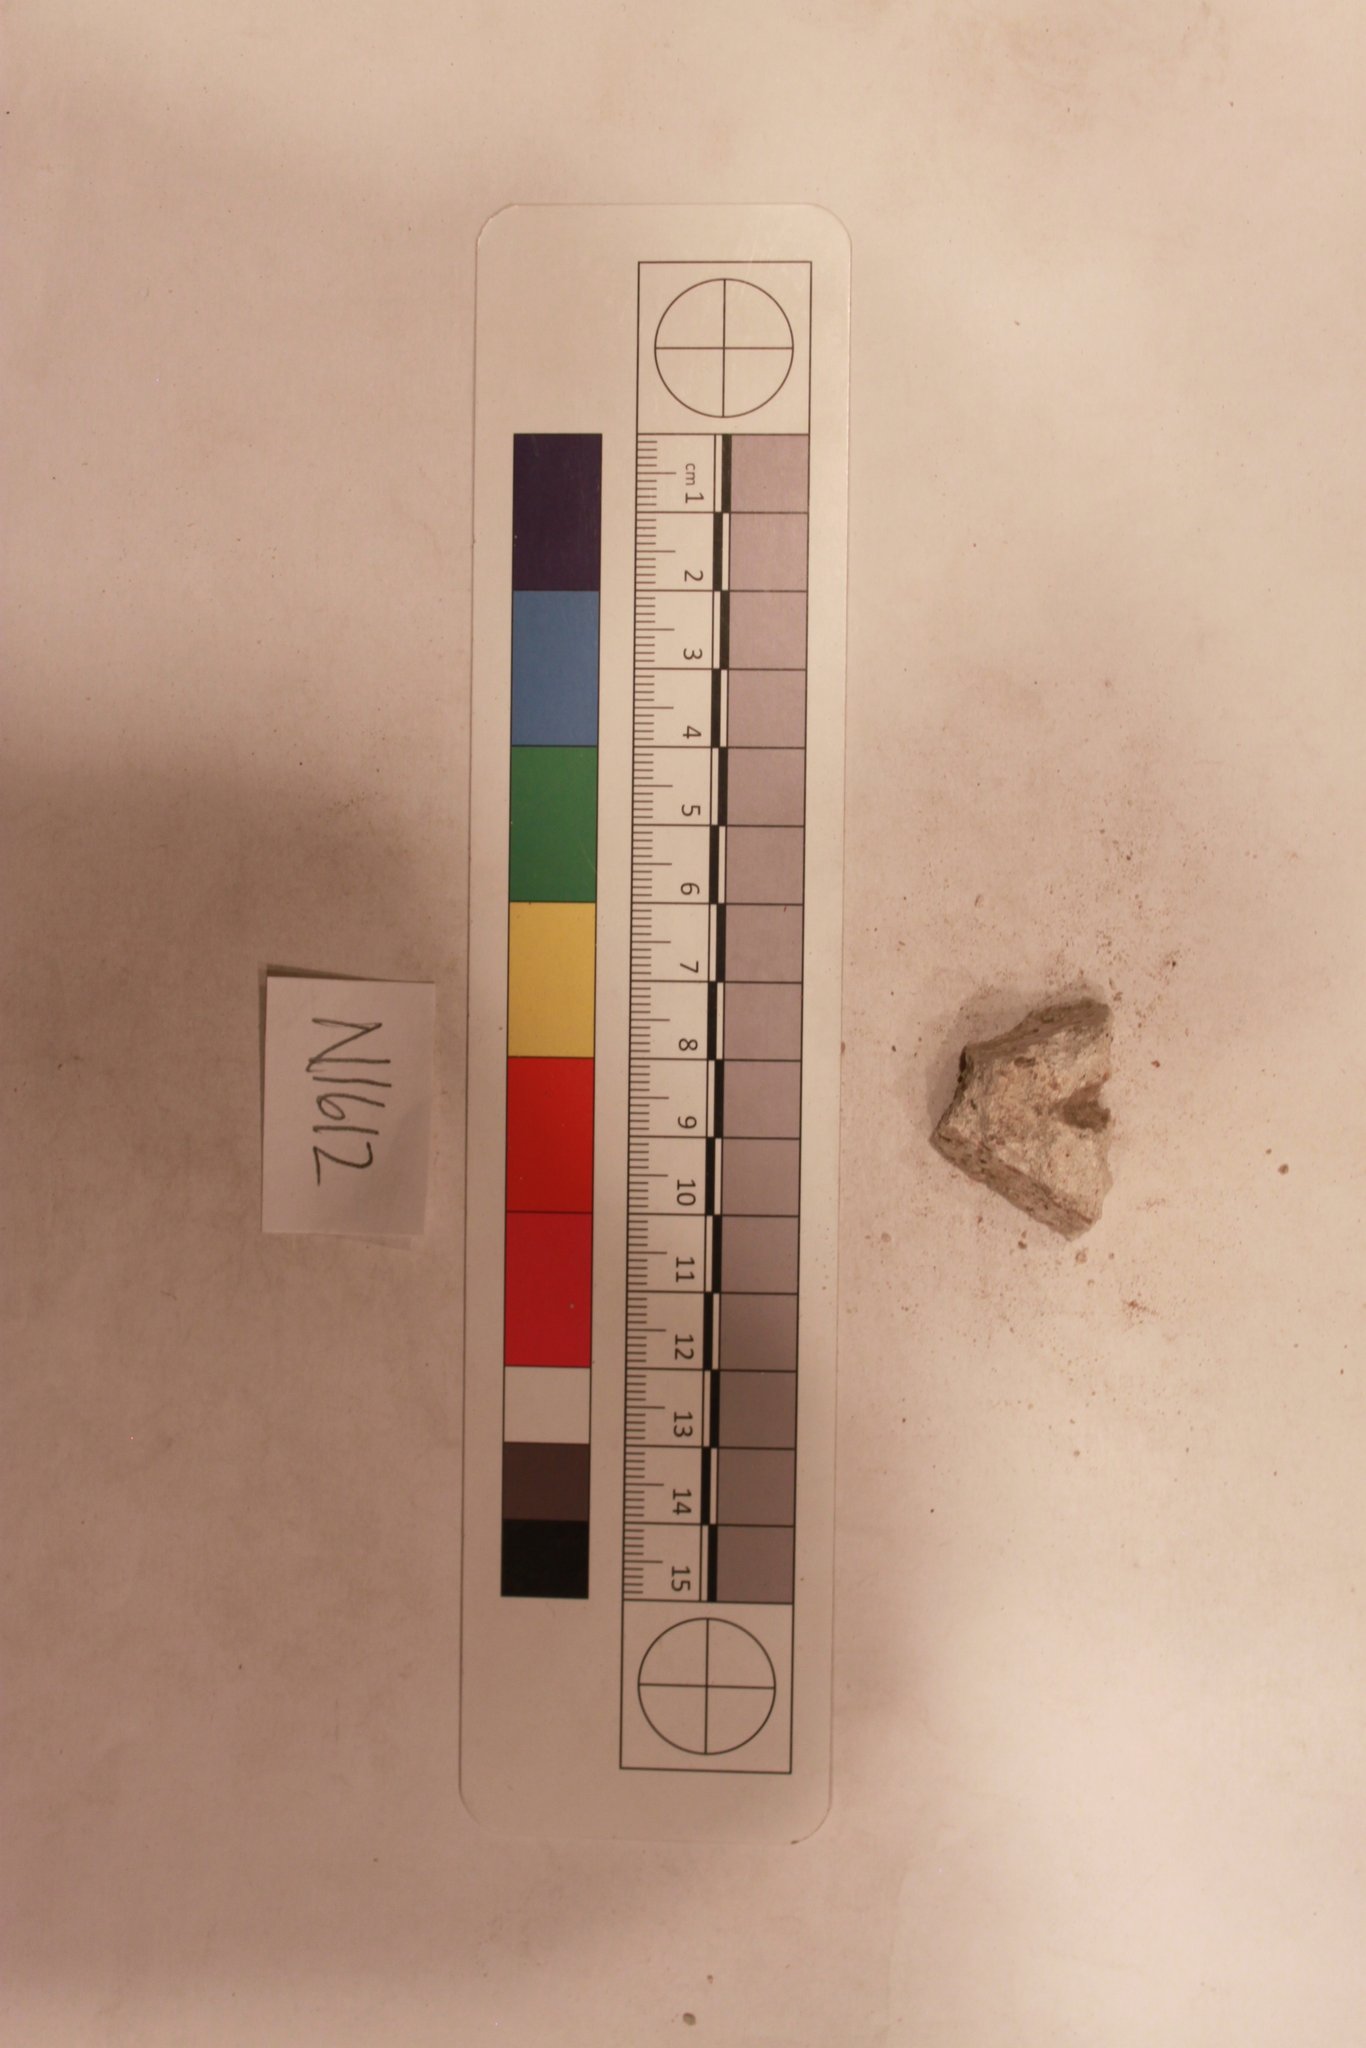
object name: fragment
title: Stucco Fragment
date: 701-1200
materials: plaster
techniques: carving, painting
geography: iran